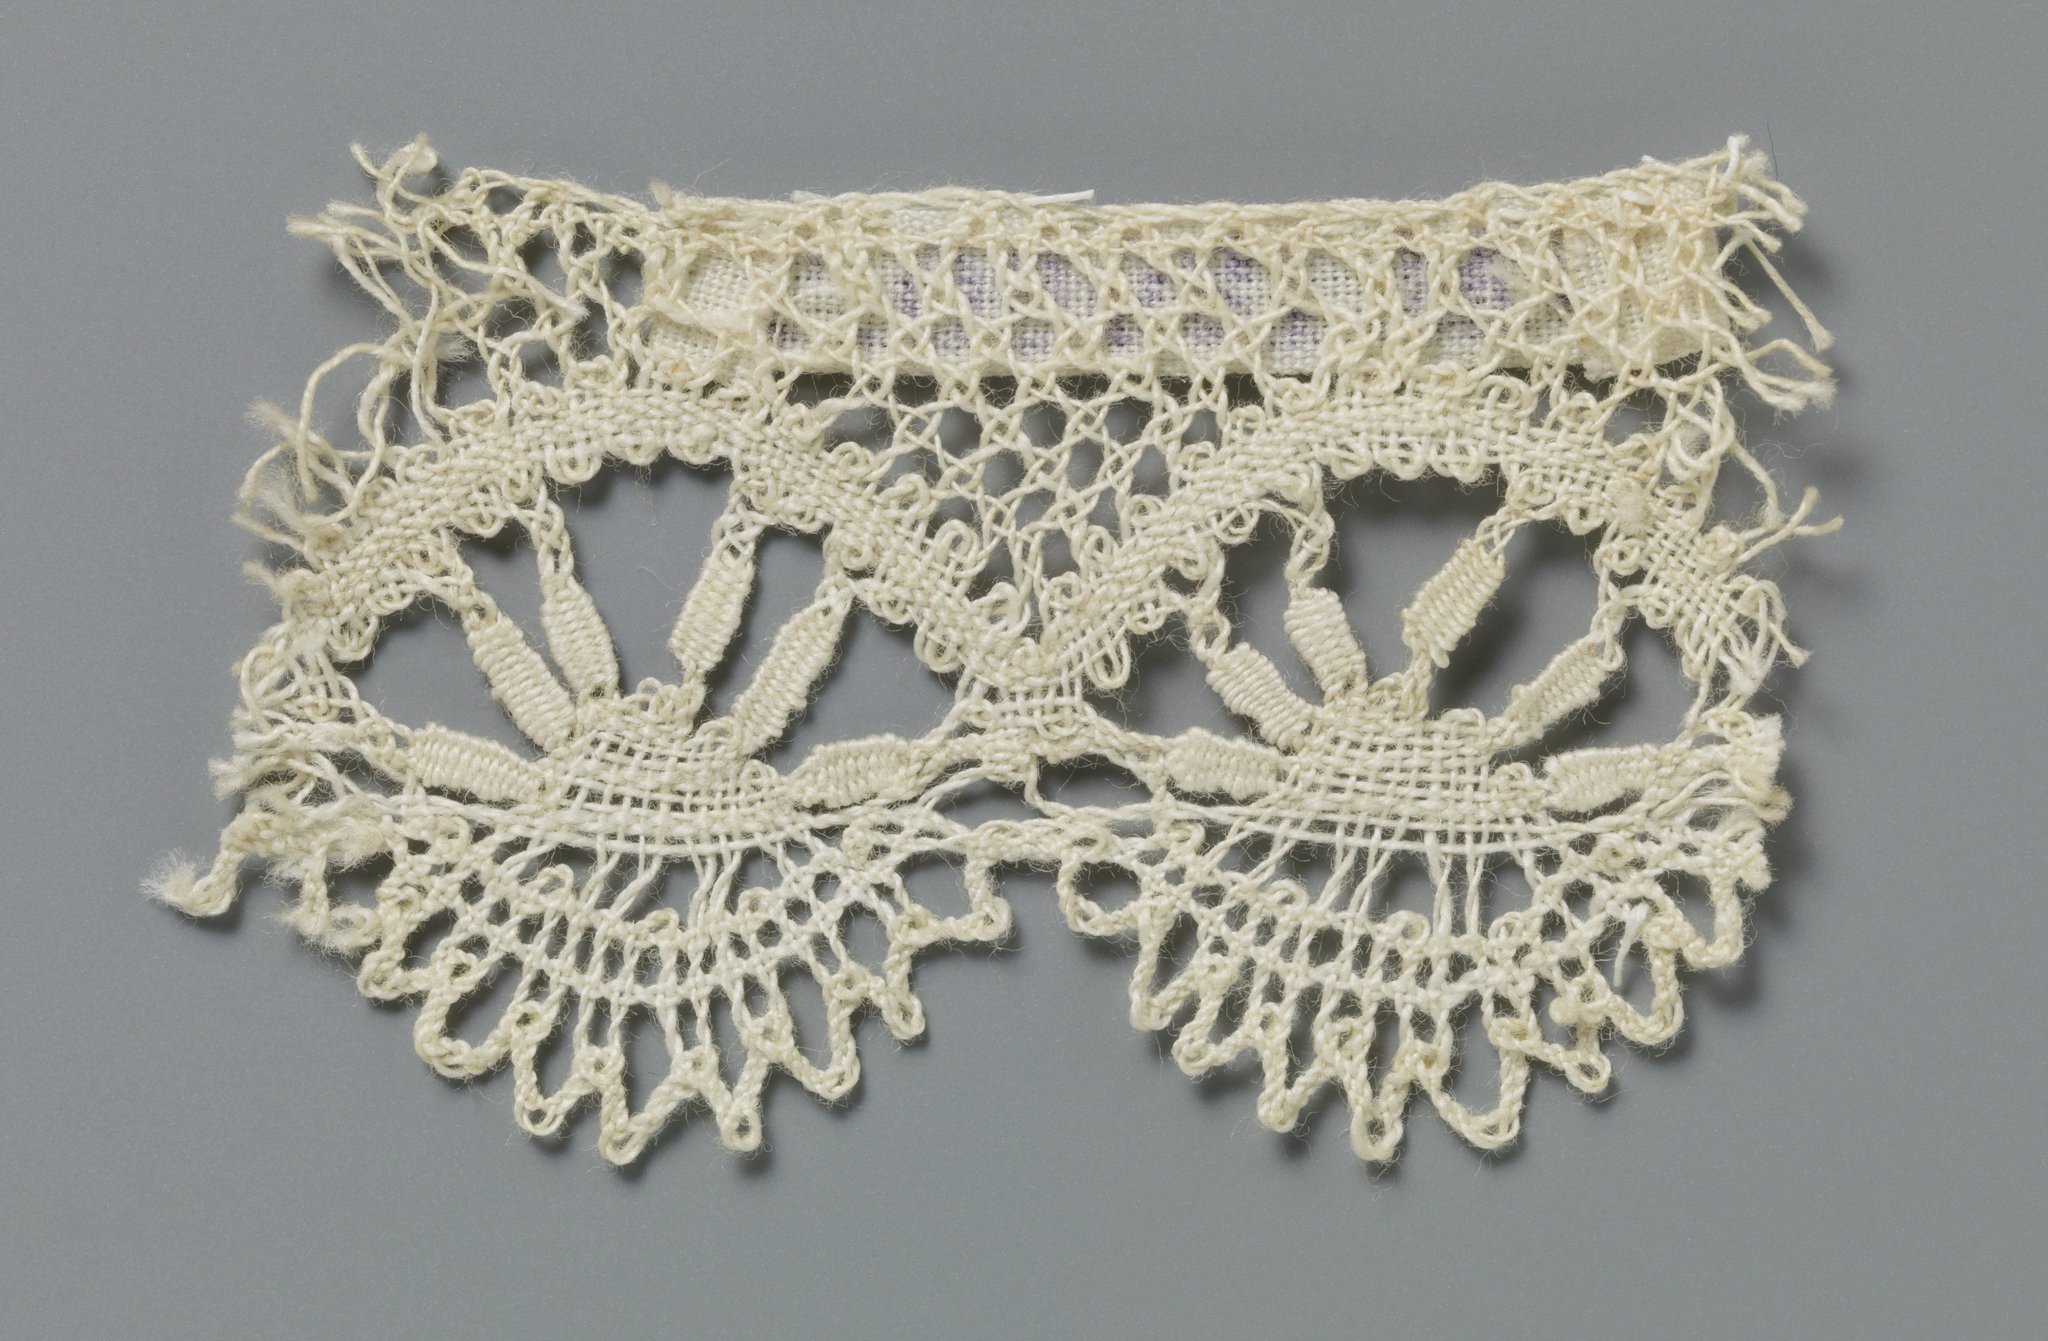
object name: strip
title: Strook kloskant met opkomende zon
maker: Anonymous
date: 1800-1899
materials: cotton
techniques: lace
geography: buckingham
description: Strook naturelkleurige kloskant, Cluny-kant. Het zich herhalende patroon bestaat uit een cirkel met daarin een opkomende of ondergaande zon. De zon is gemaakt in linnenslag en de stralen zijn gemaakt in vormslag. De bovenkant van de cirkel is gemaakt met een bandje in linnenslag. De onderkant van de cirkel, die tevens een halfronde schulp vormt, is afgewerkt met een zigzaggend vlechtje met op elk hoekpunt een picot. De opeenvolgende cirkels zijn aan de bovenkant met elkaar verbonden door een maasgrond, een stroptraliegrond. De bovenzijde van de strook is recht afgewerkt.